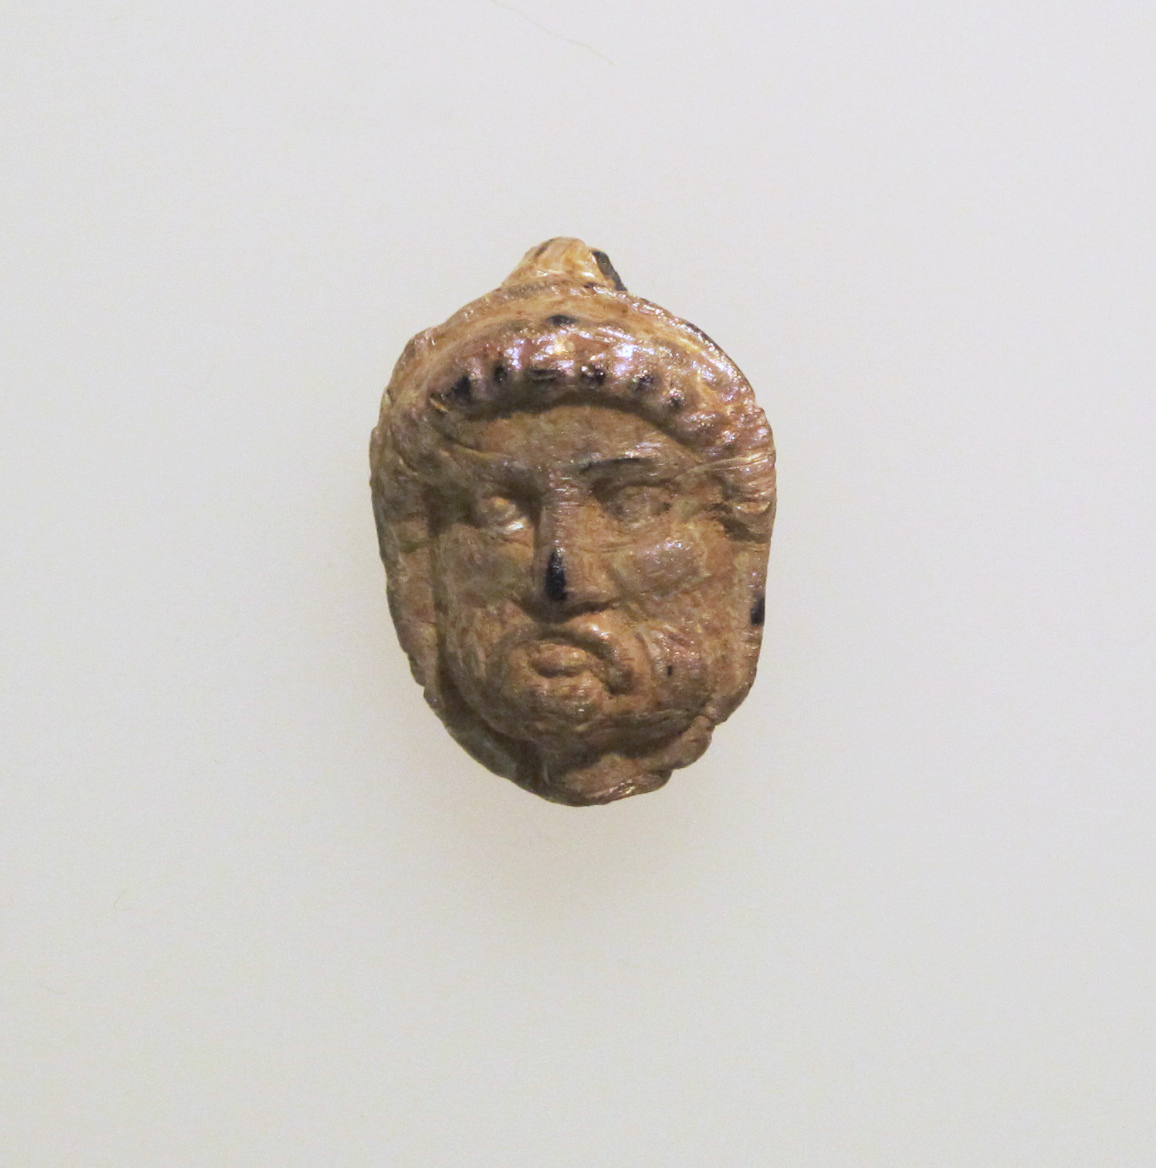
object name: pendant with male mask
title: Glass double-headed pendant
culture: punic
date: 334-201 BCE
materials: glass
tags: heads